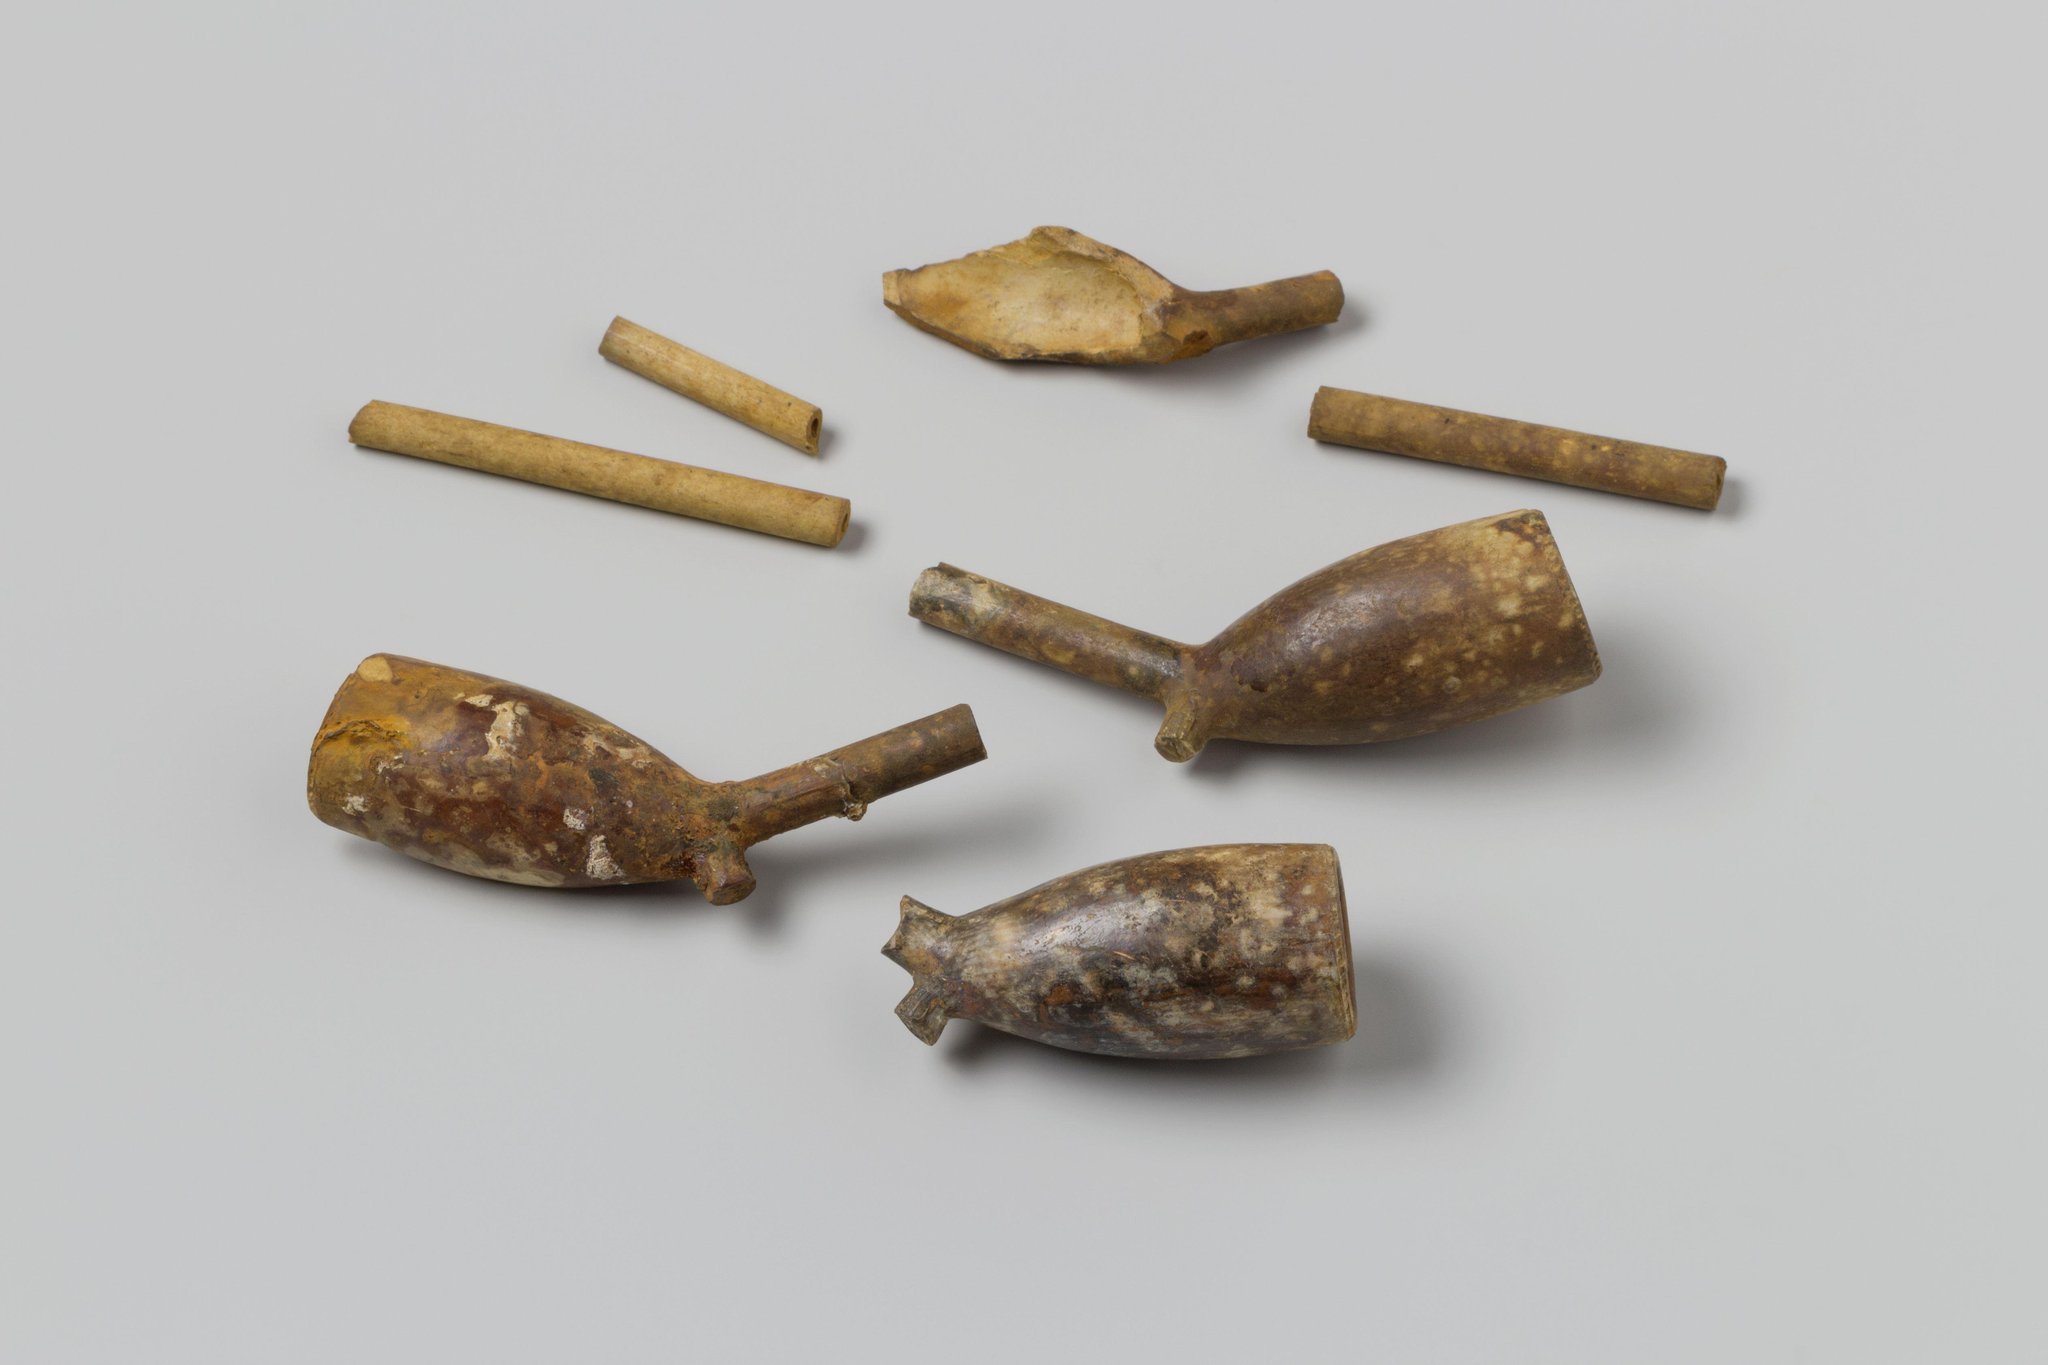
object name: pipe bowl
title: Fragmenten pijpenkoppen en pijpenstelen uit het wrak van de Oost-Indiëvaarder Hollandia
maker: Anonymous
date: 1700-1743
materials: clay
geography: netherlands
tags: verenigde oostindische compagnie, hollandia (schip), annet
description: Pipe, bowl, heelmark: crowned 57; 2hsm3, fragm, no hsm.